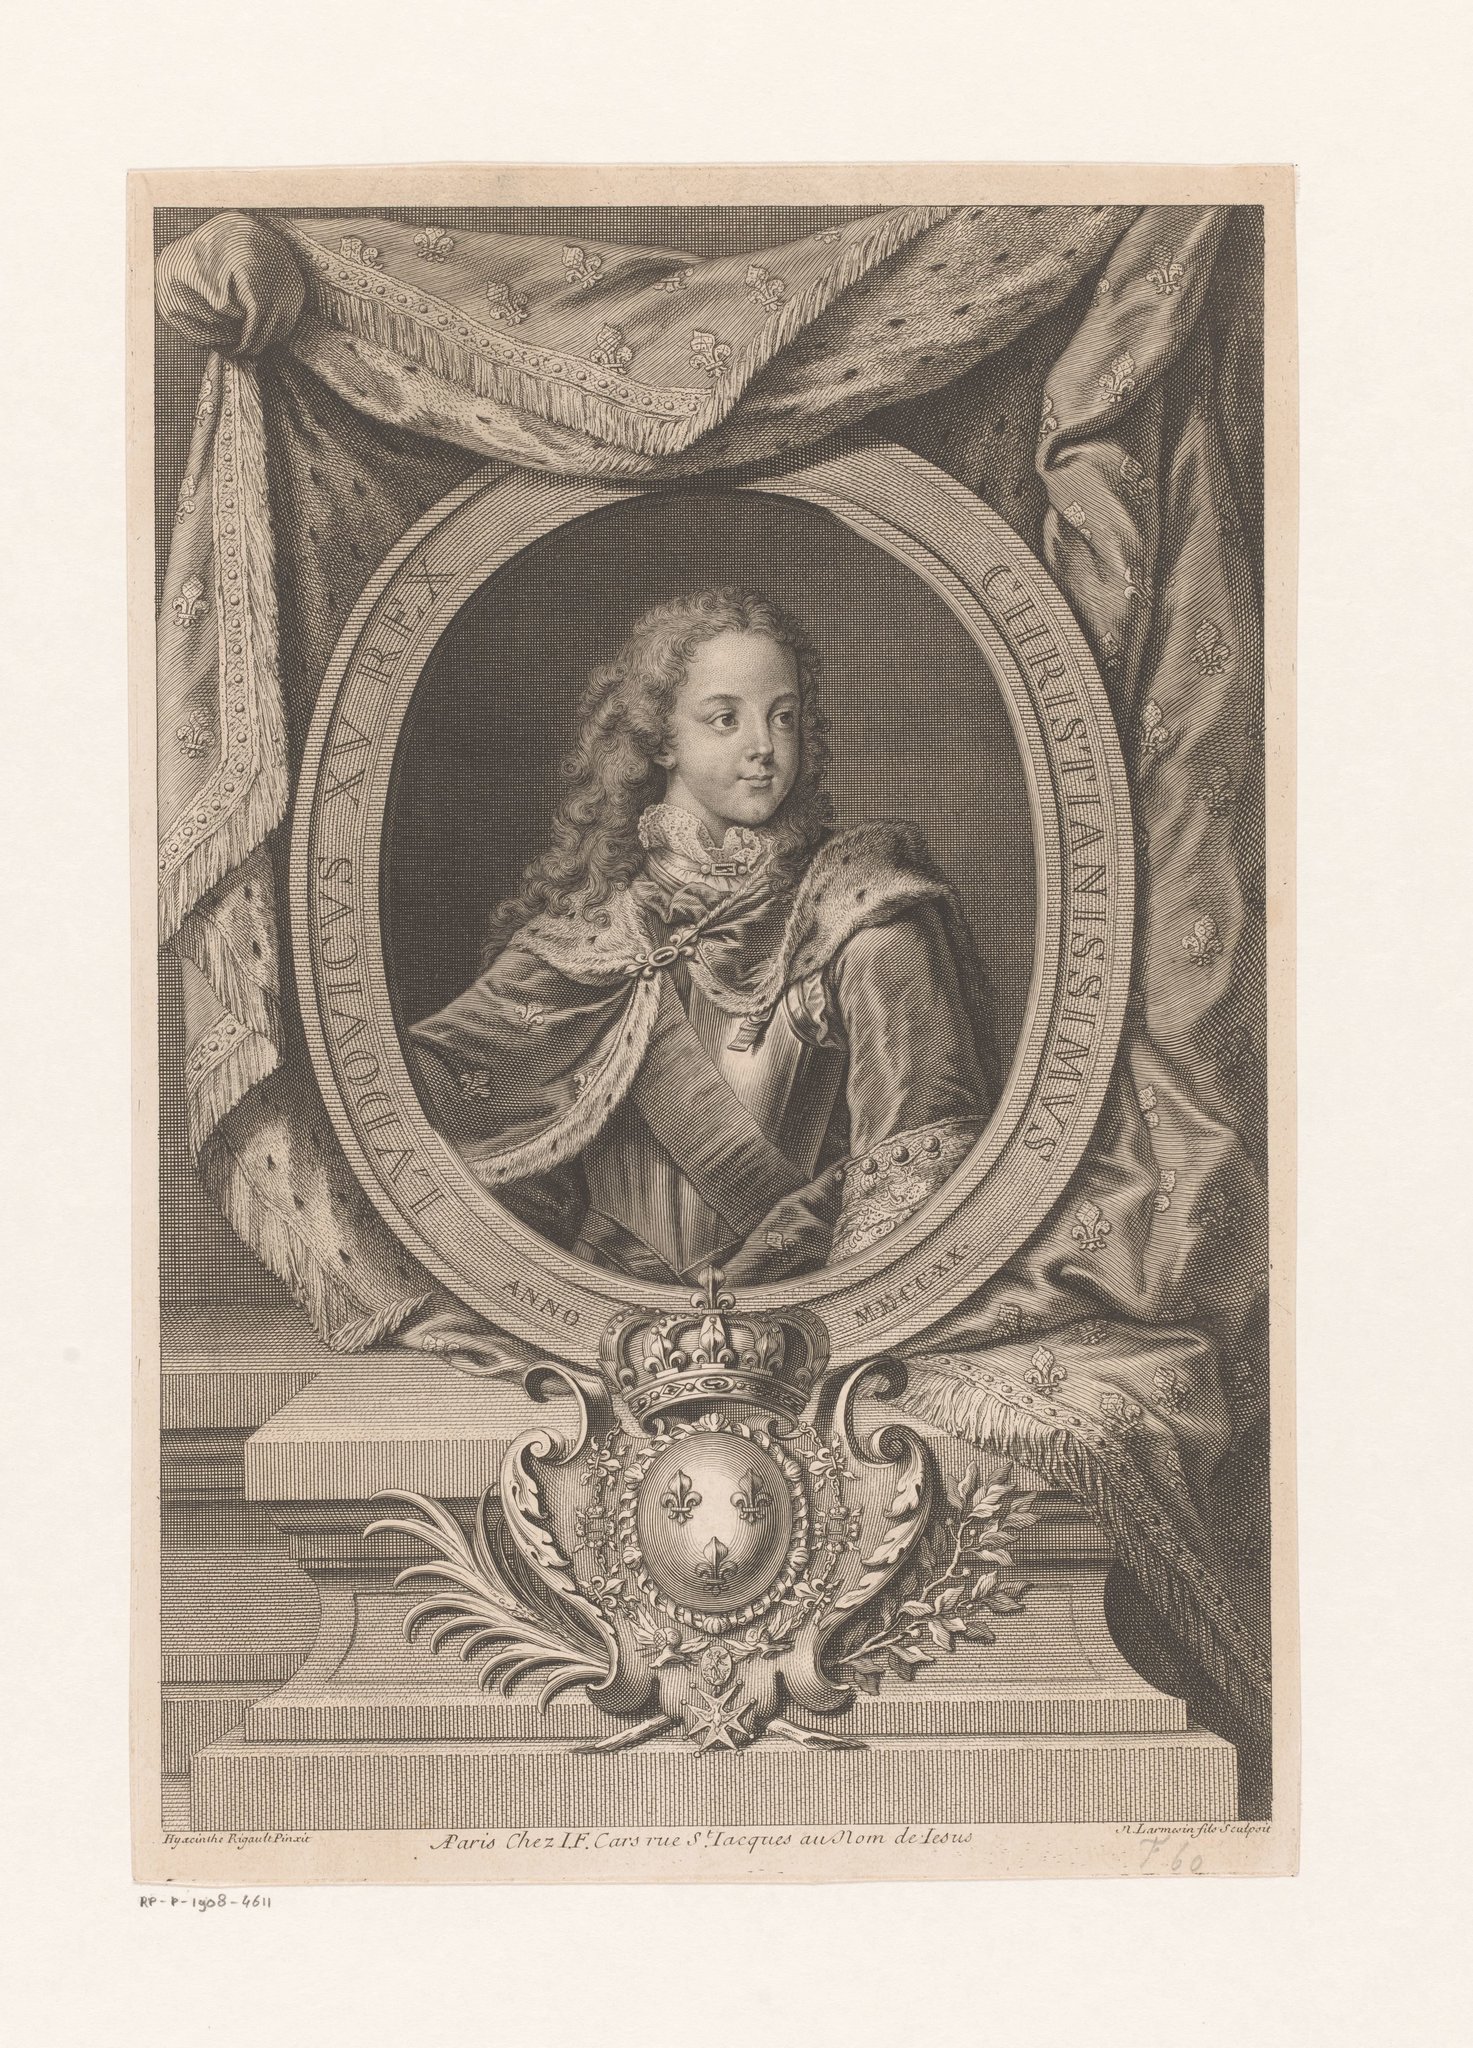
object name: print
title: Portret van Lodewijk XV, koning van Franrijk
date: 1720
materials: paper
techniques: engraving, etching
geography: paris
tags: louis xv of france, historical persons, king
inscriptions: collector's mark: Lugt 2228